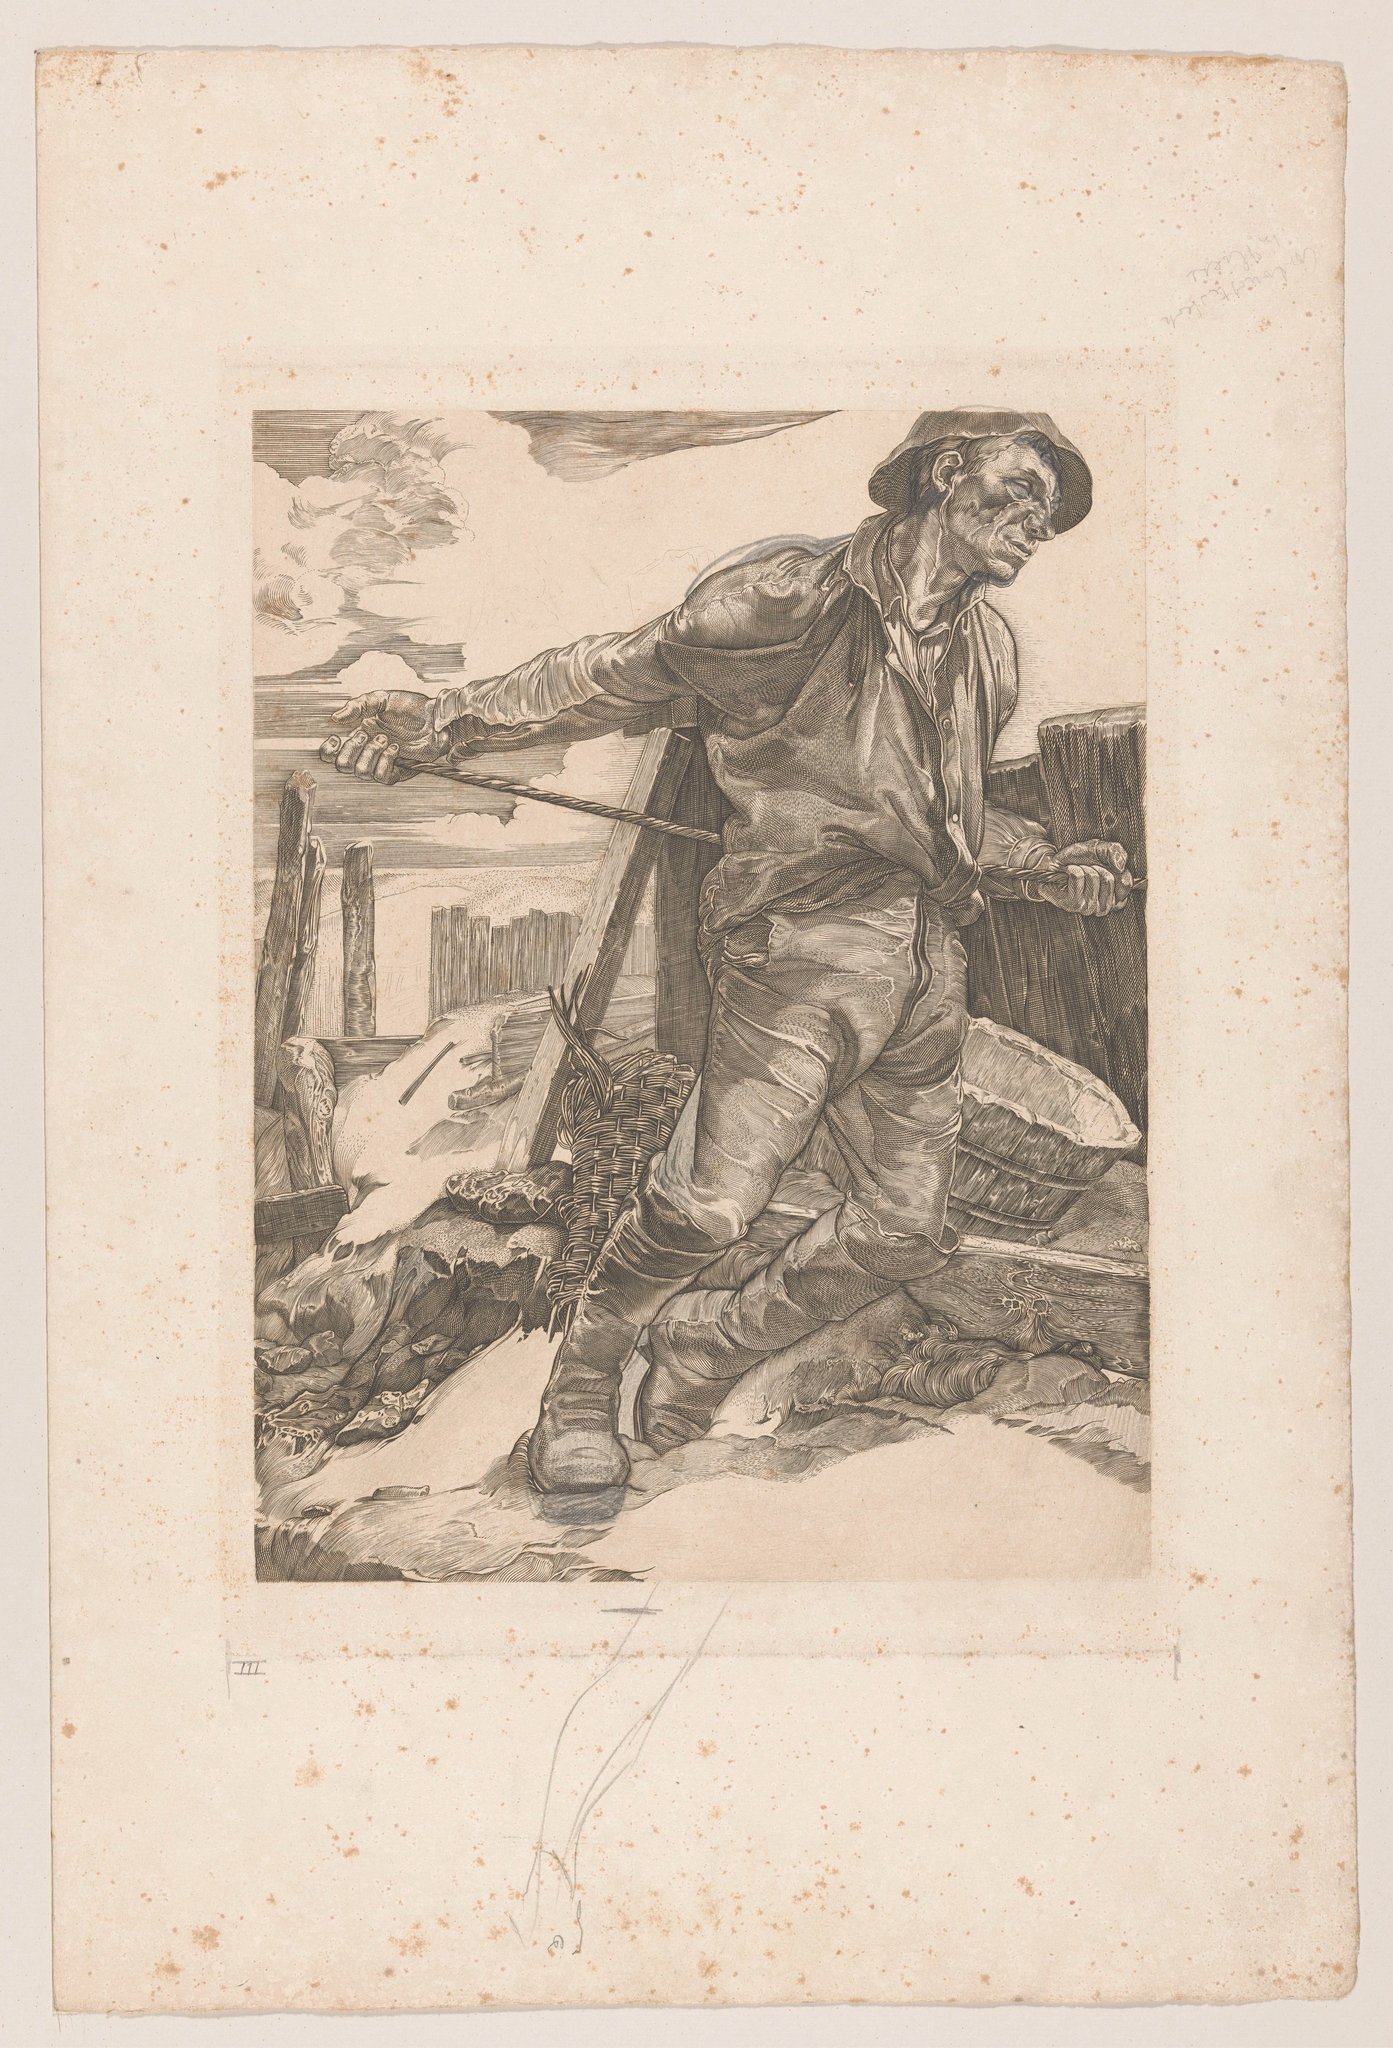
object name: print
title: Polderjongen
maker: johannes josephus aarts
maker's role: draughtsman, print maker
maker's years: 1871-1934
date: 1881-1934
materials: paper, pencil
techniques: engraving, intaglio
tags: working class, labourers, tools, aids, implements ~ crafts and industries: rope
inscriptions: collector's mark: Lugt 2166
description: Een arbeider die een hoed en laarzen draagt, laat een touw vieren. Op de achtergrond onder meer een mand, een kuip en een hek.